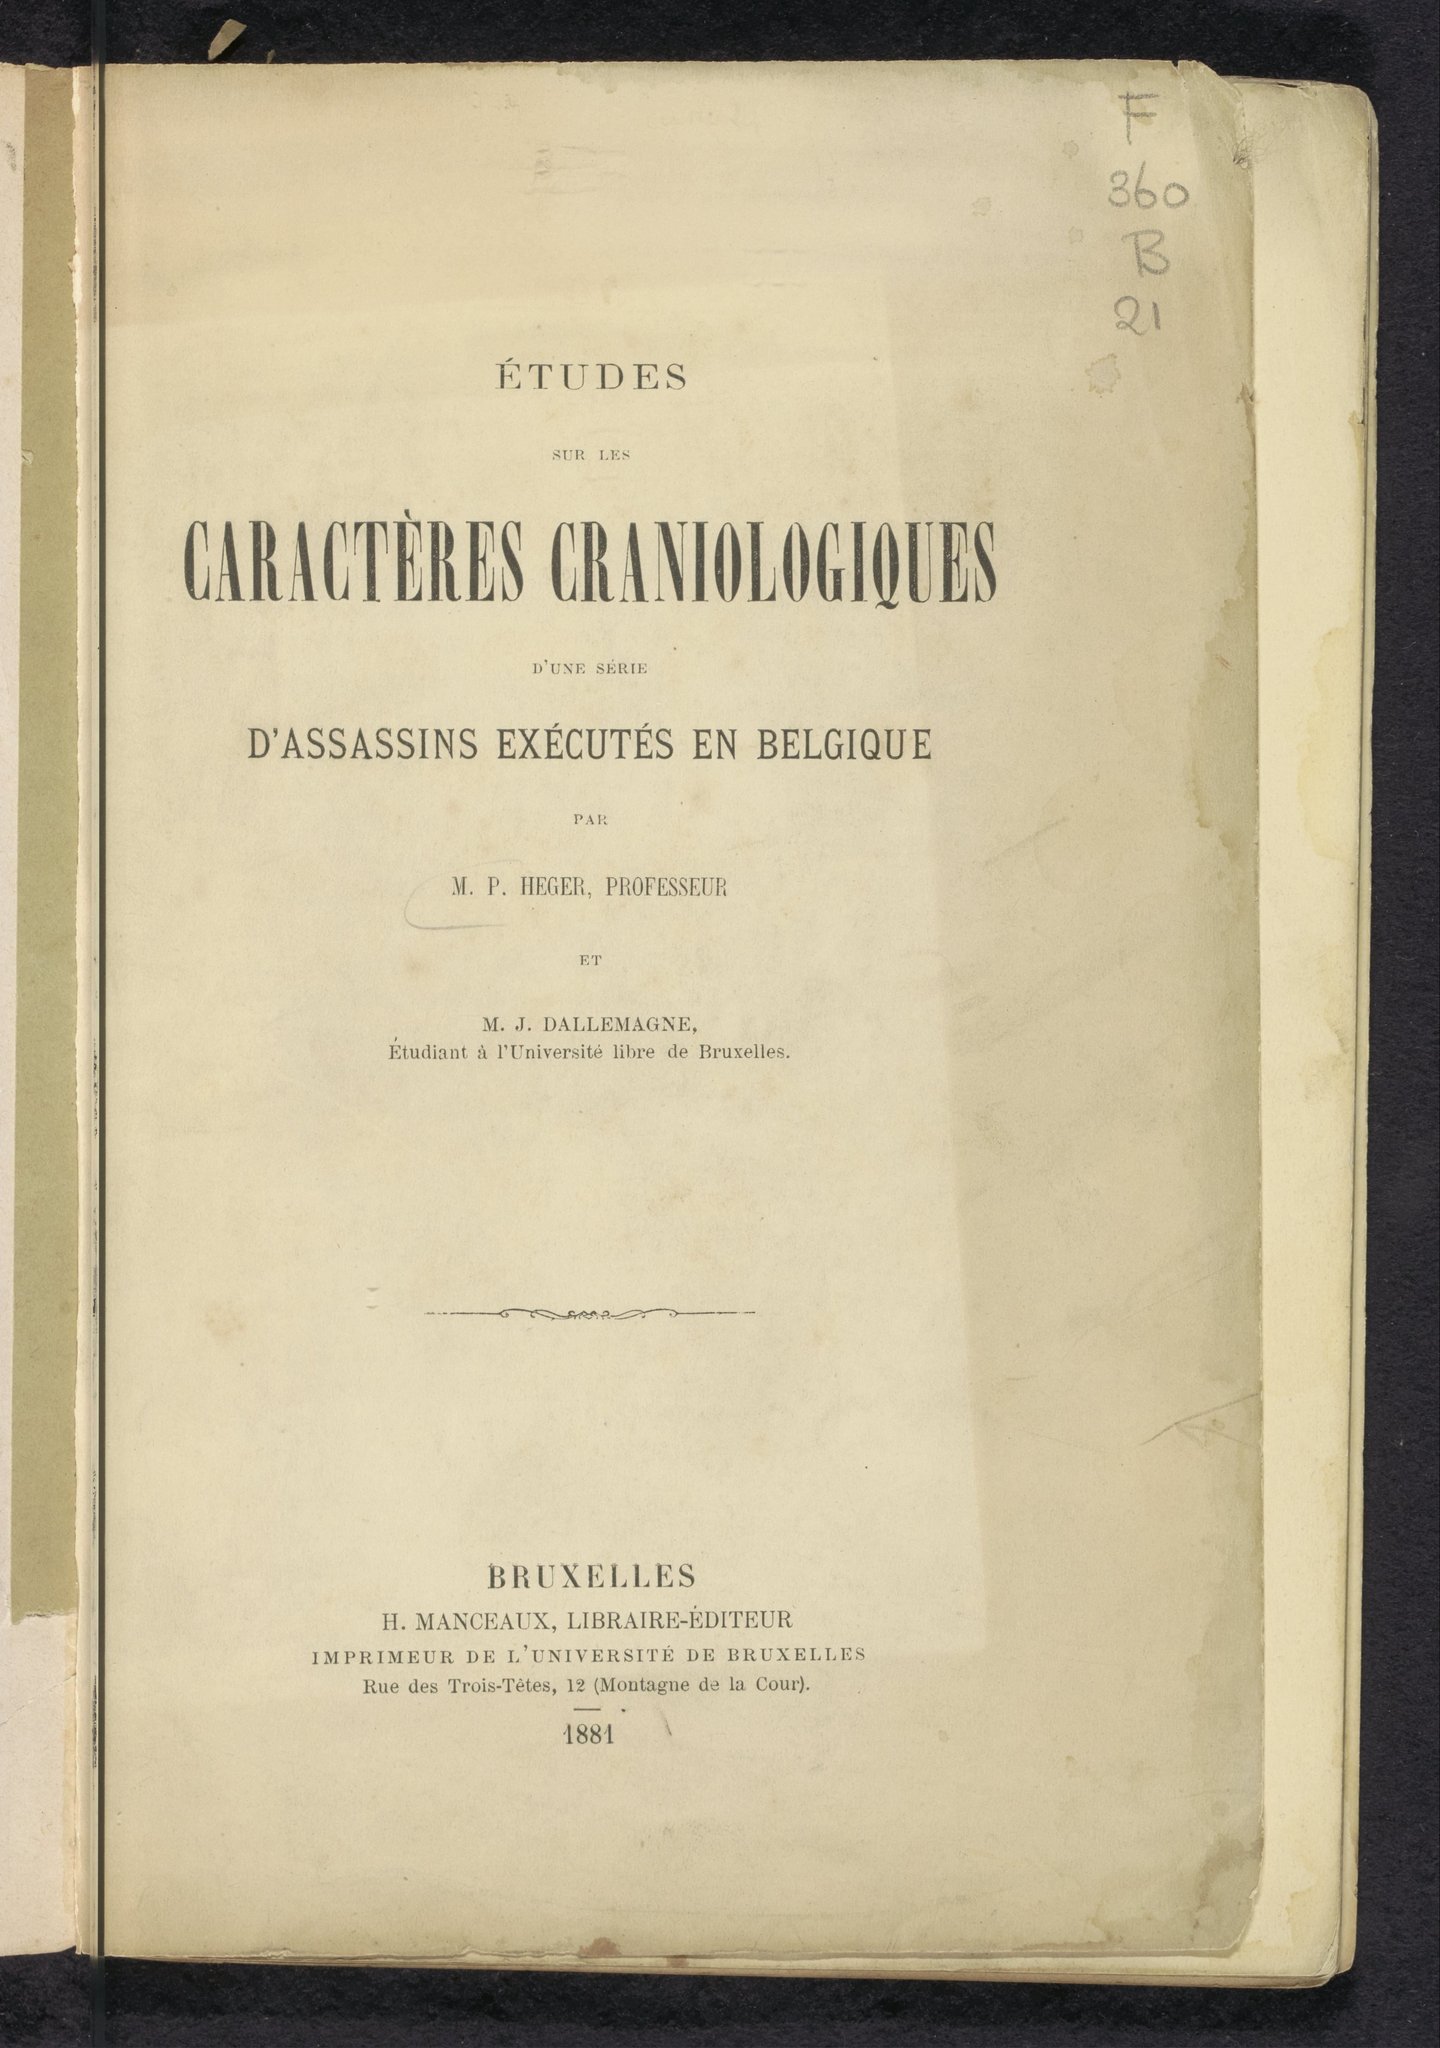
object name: book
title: Études sur les caractères craniologiques d'une série d'assassins exécutés en Belgique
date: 1881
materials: paper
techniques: photoaquatint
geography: brussels